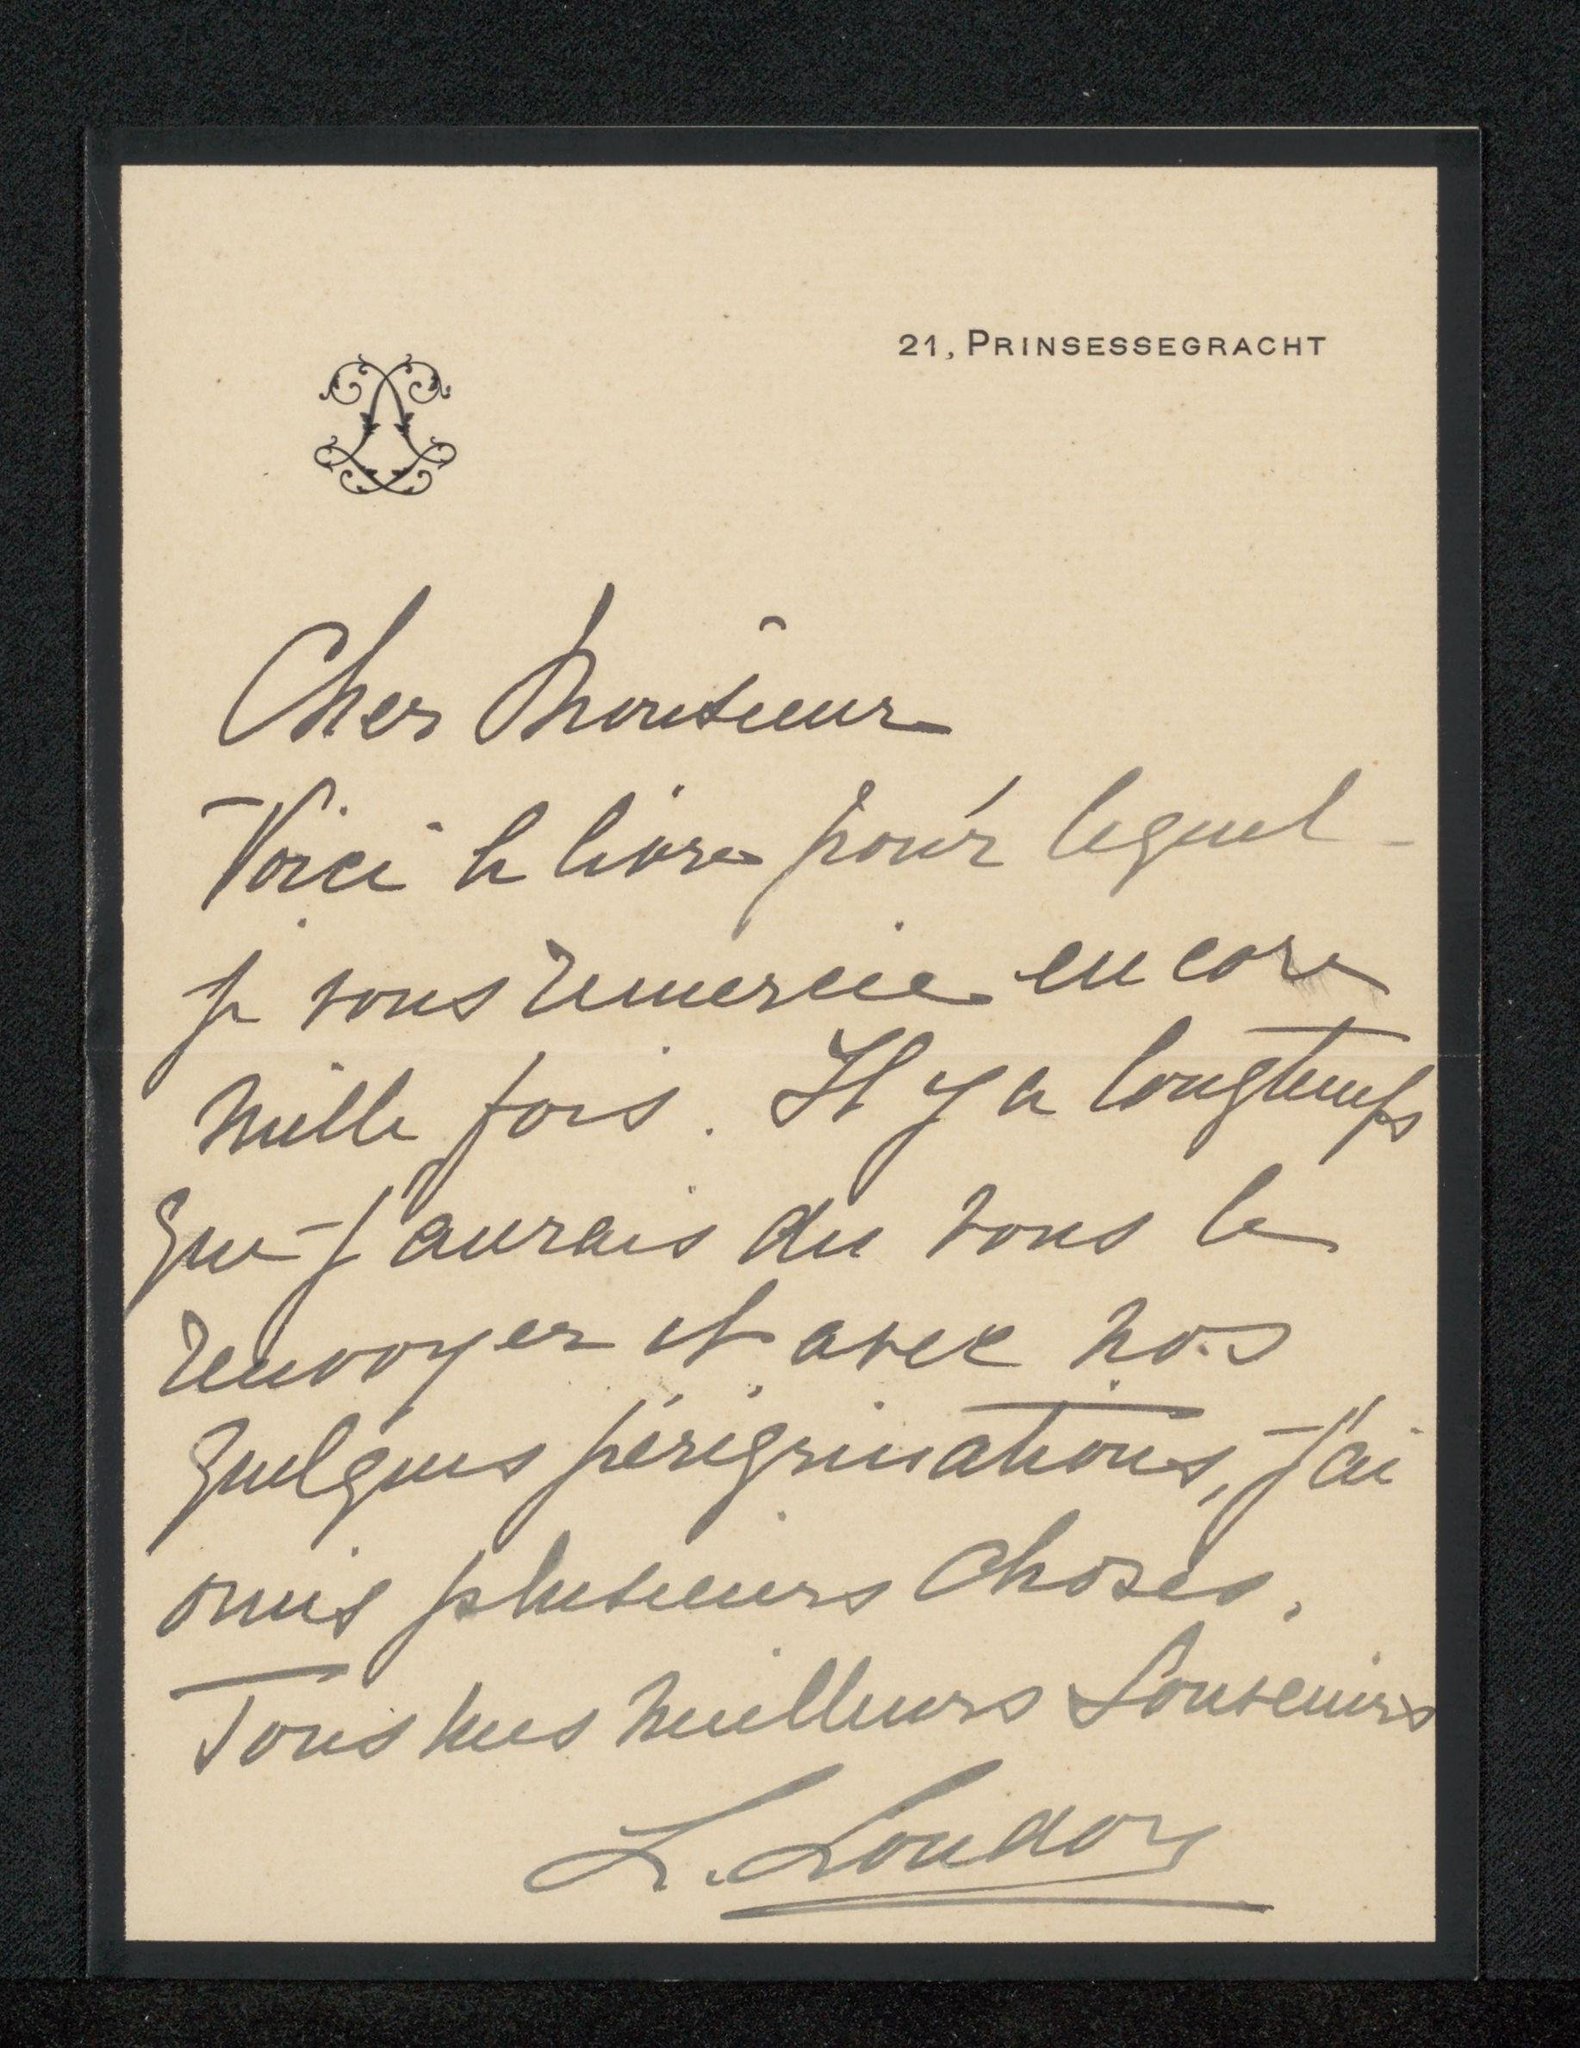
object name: letter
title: Brief aan Philip Zilcken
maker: l. loudon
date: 1867-1930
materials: ink, paper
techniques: pen, printing, writing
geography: the hague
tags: the hague, painter, draughtsman, philip zilcken, printed matter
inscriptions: collector's mark: ‘RPK’